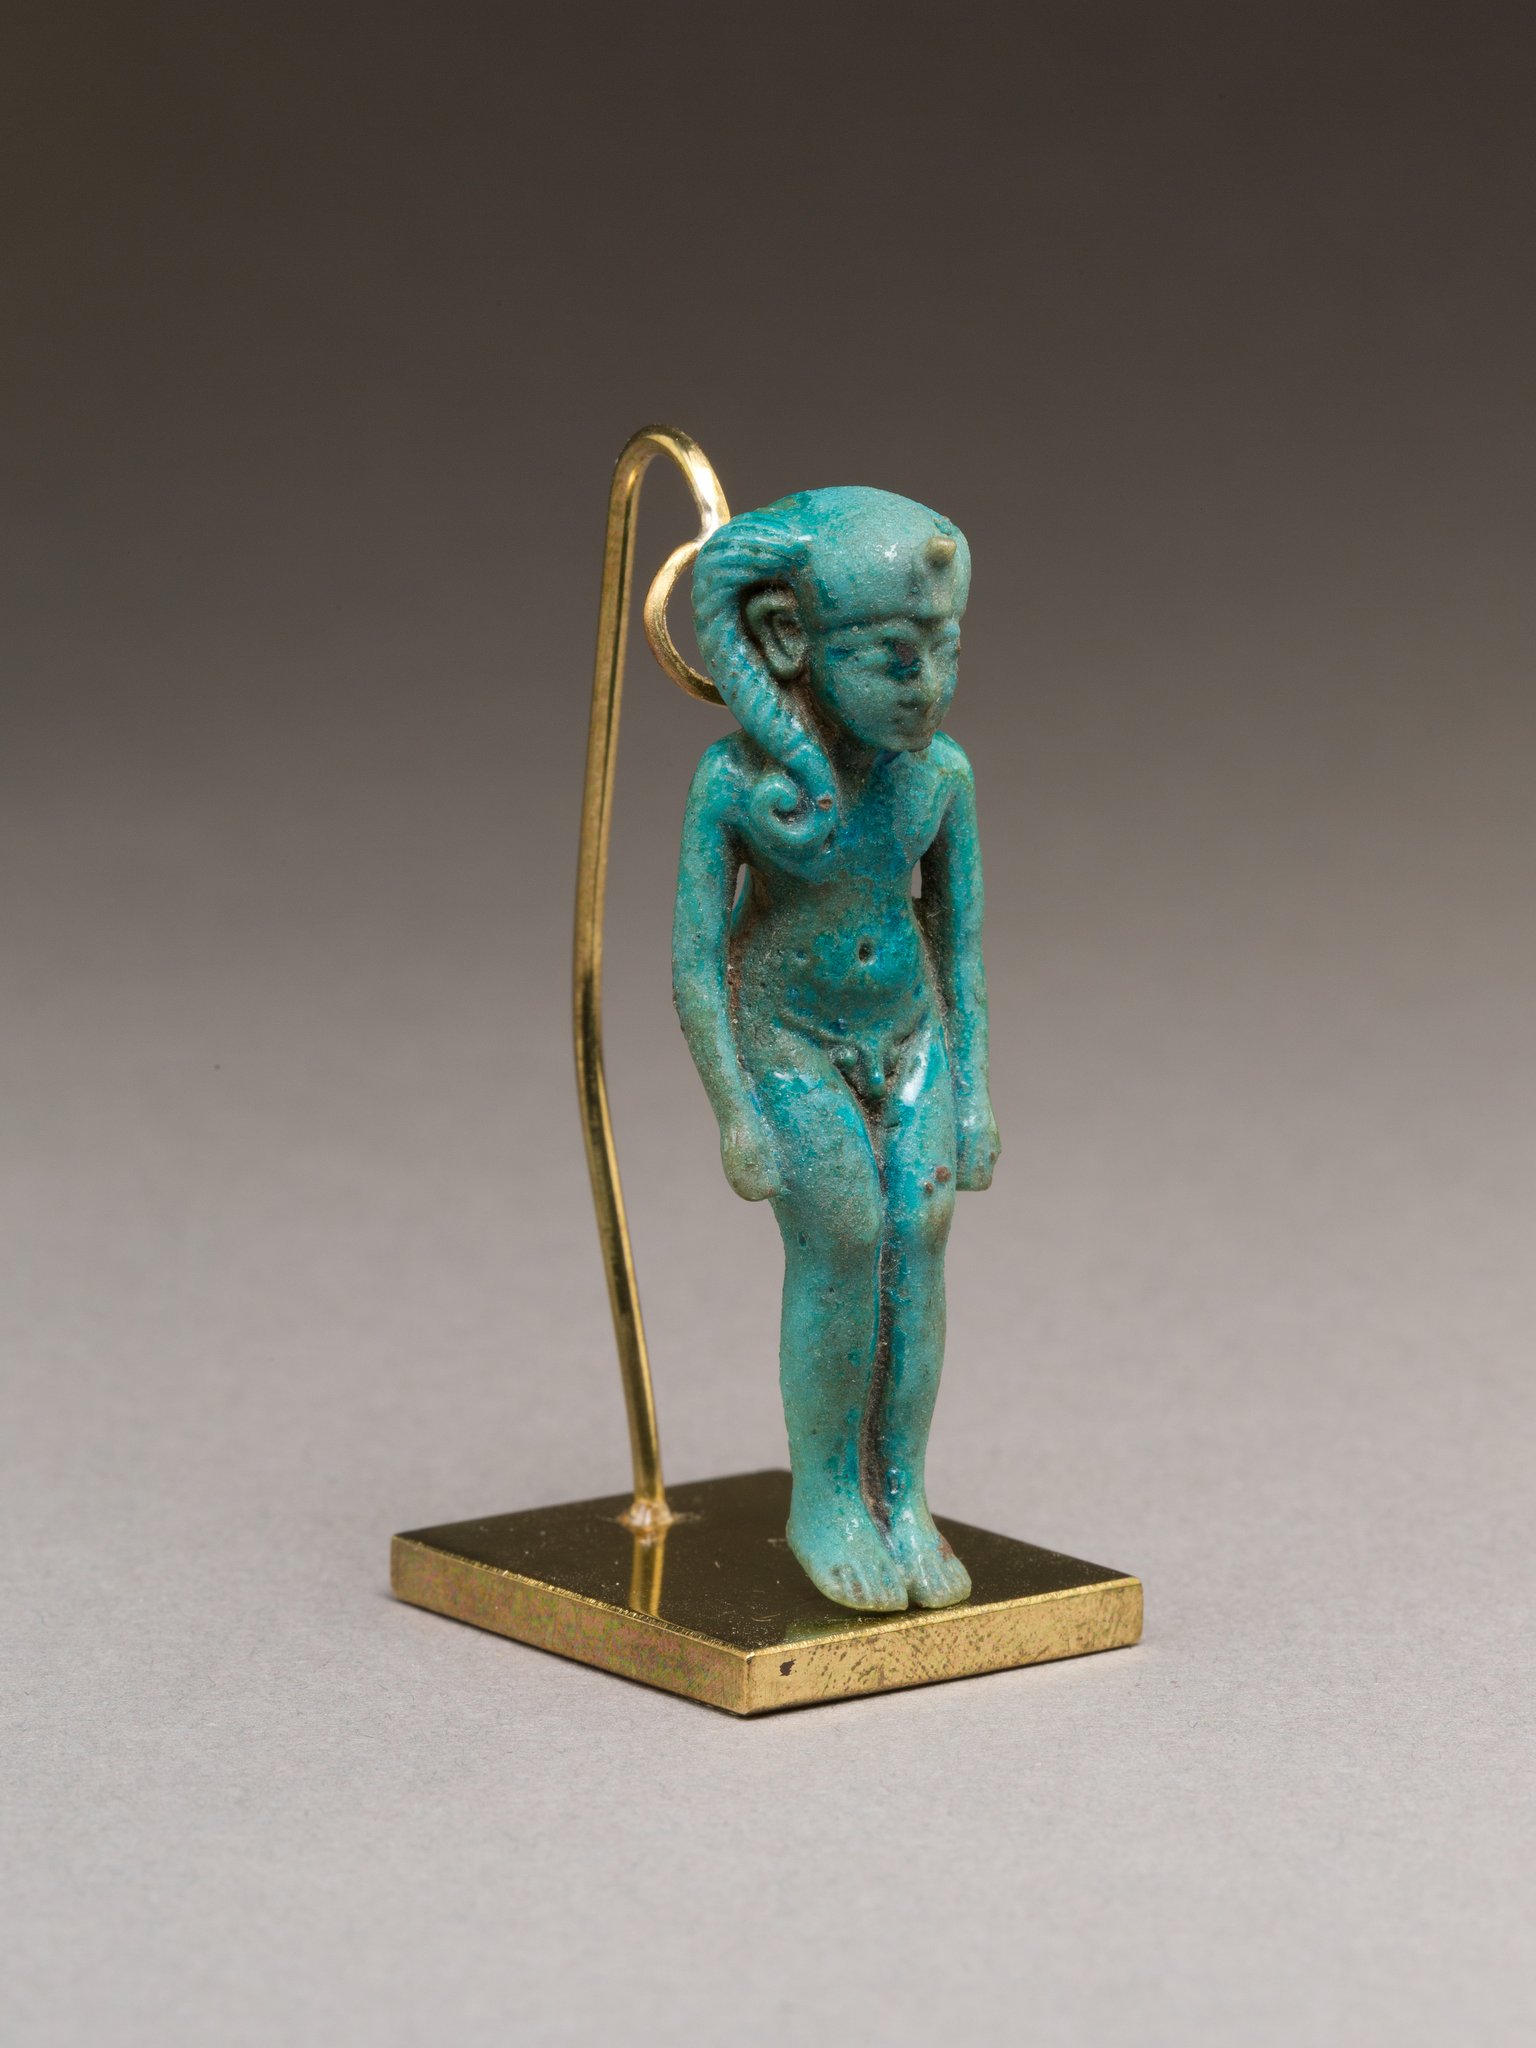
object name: amulet, harpokrates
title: Child god (Harpokrates?) amulet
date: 664-630 BCE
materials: faience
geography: egypt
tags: gods